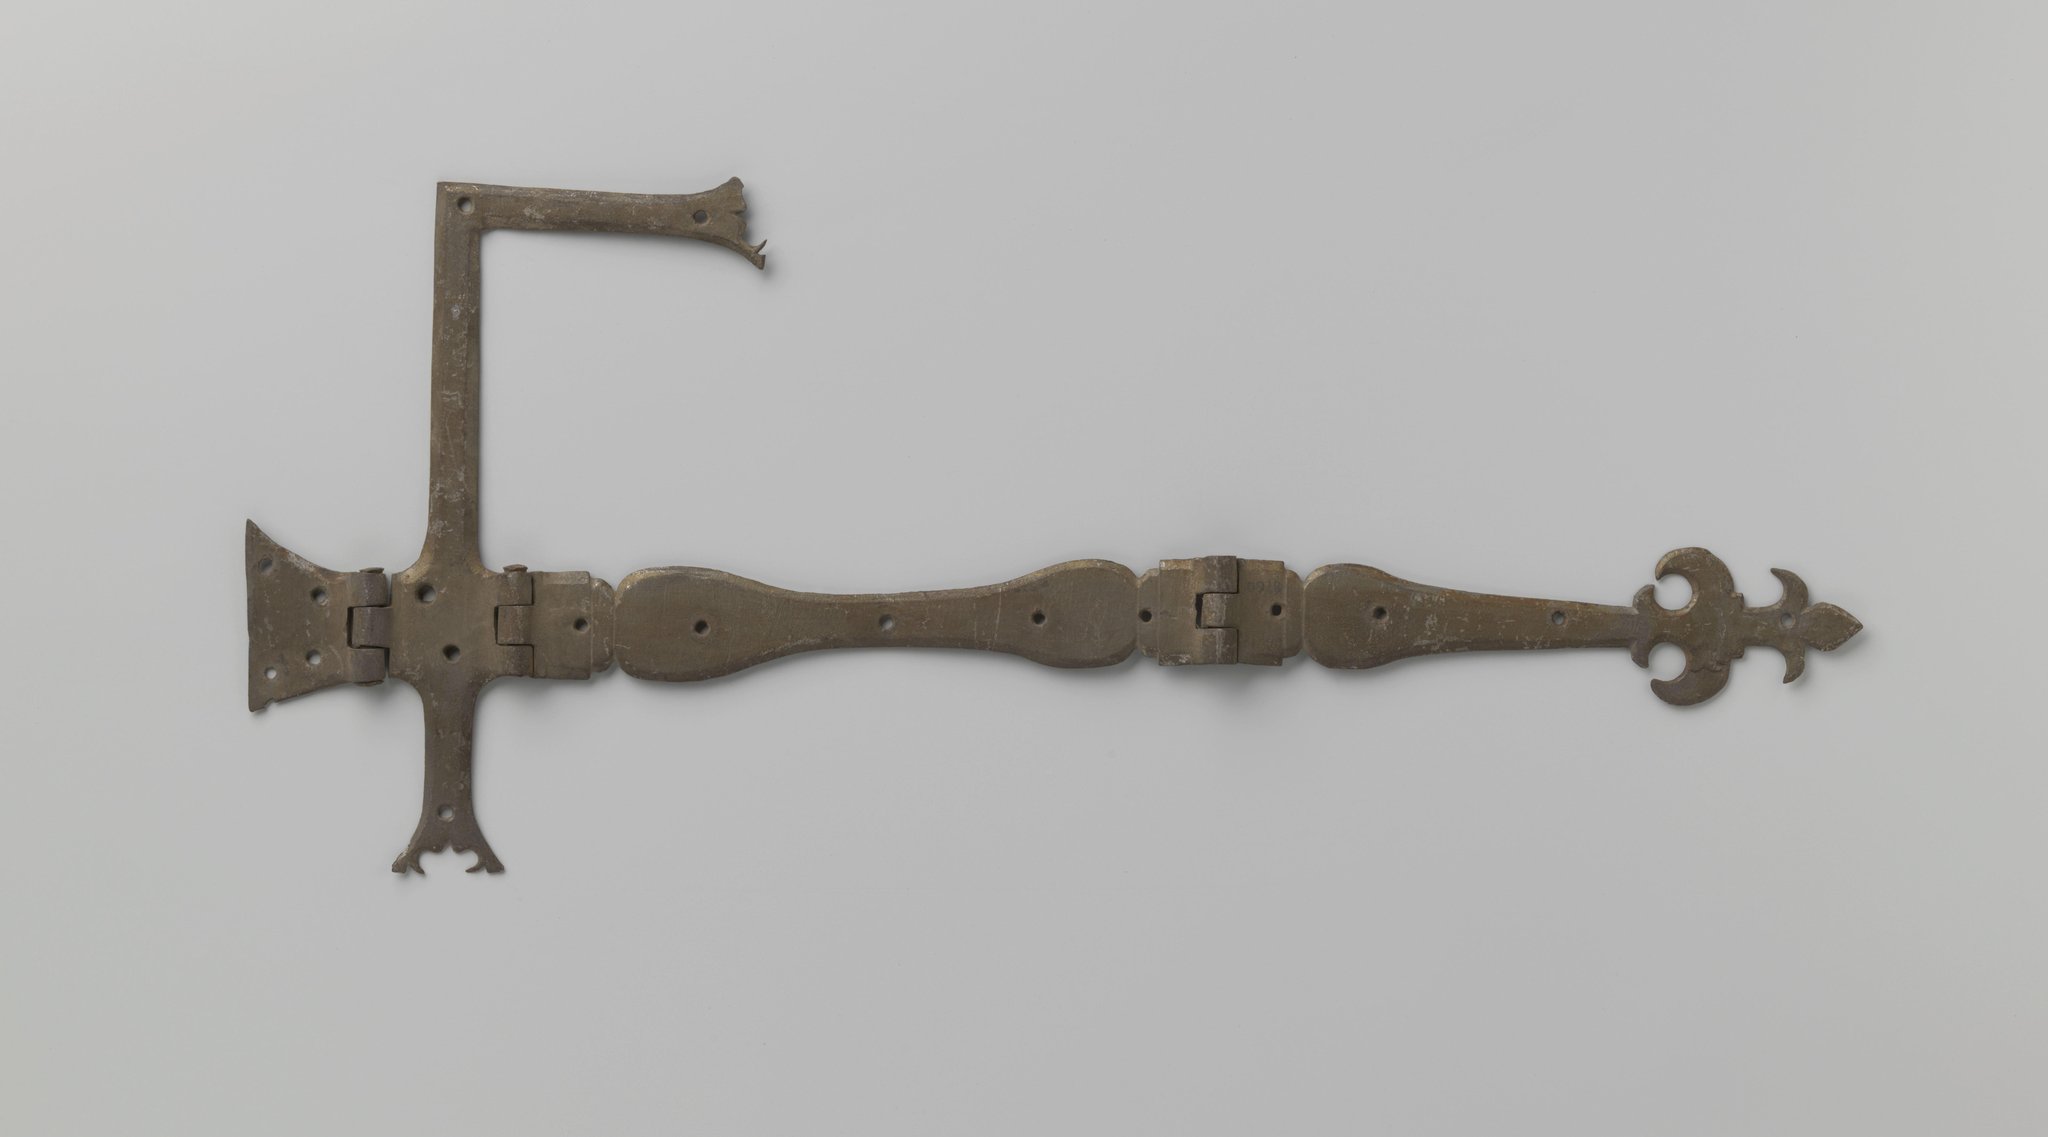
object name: beslag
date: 1400-1950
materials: iron